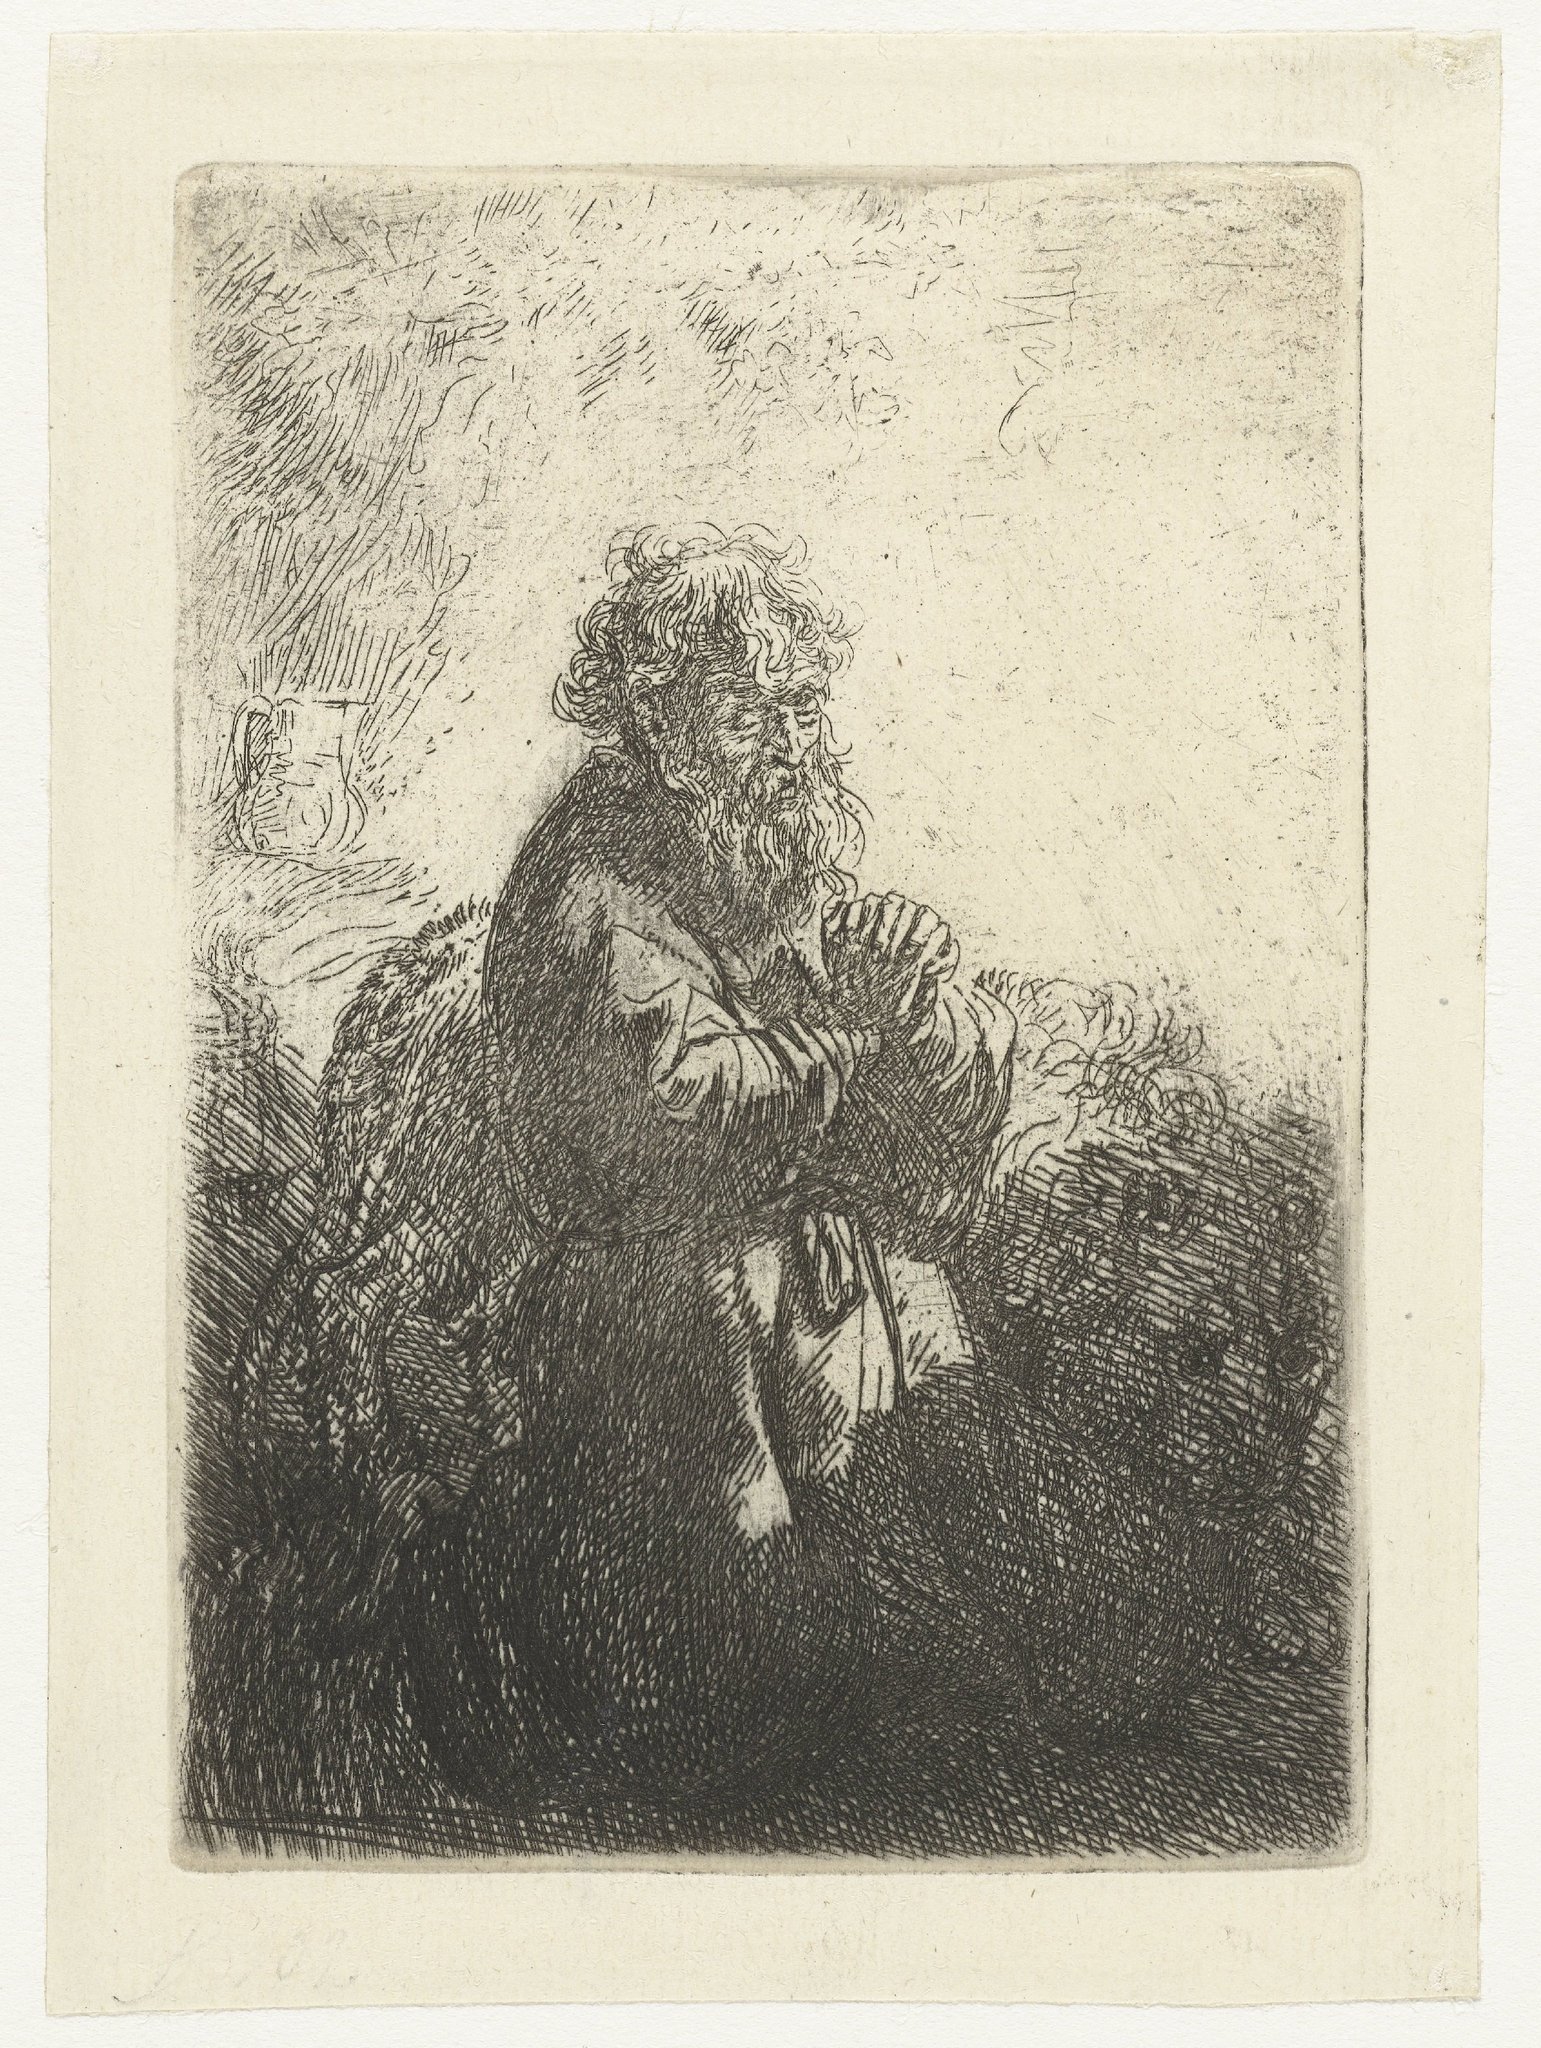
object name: print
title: St Jerome kneeling in prayer, looking down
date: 1635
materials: paper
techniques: etching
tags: the monk and hermit jerome (hieronymus); possible attributes: book, cardinal's hat, crucifix, hour-glass, lion, skull, stone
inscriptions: inscription: ‘Coppier’